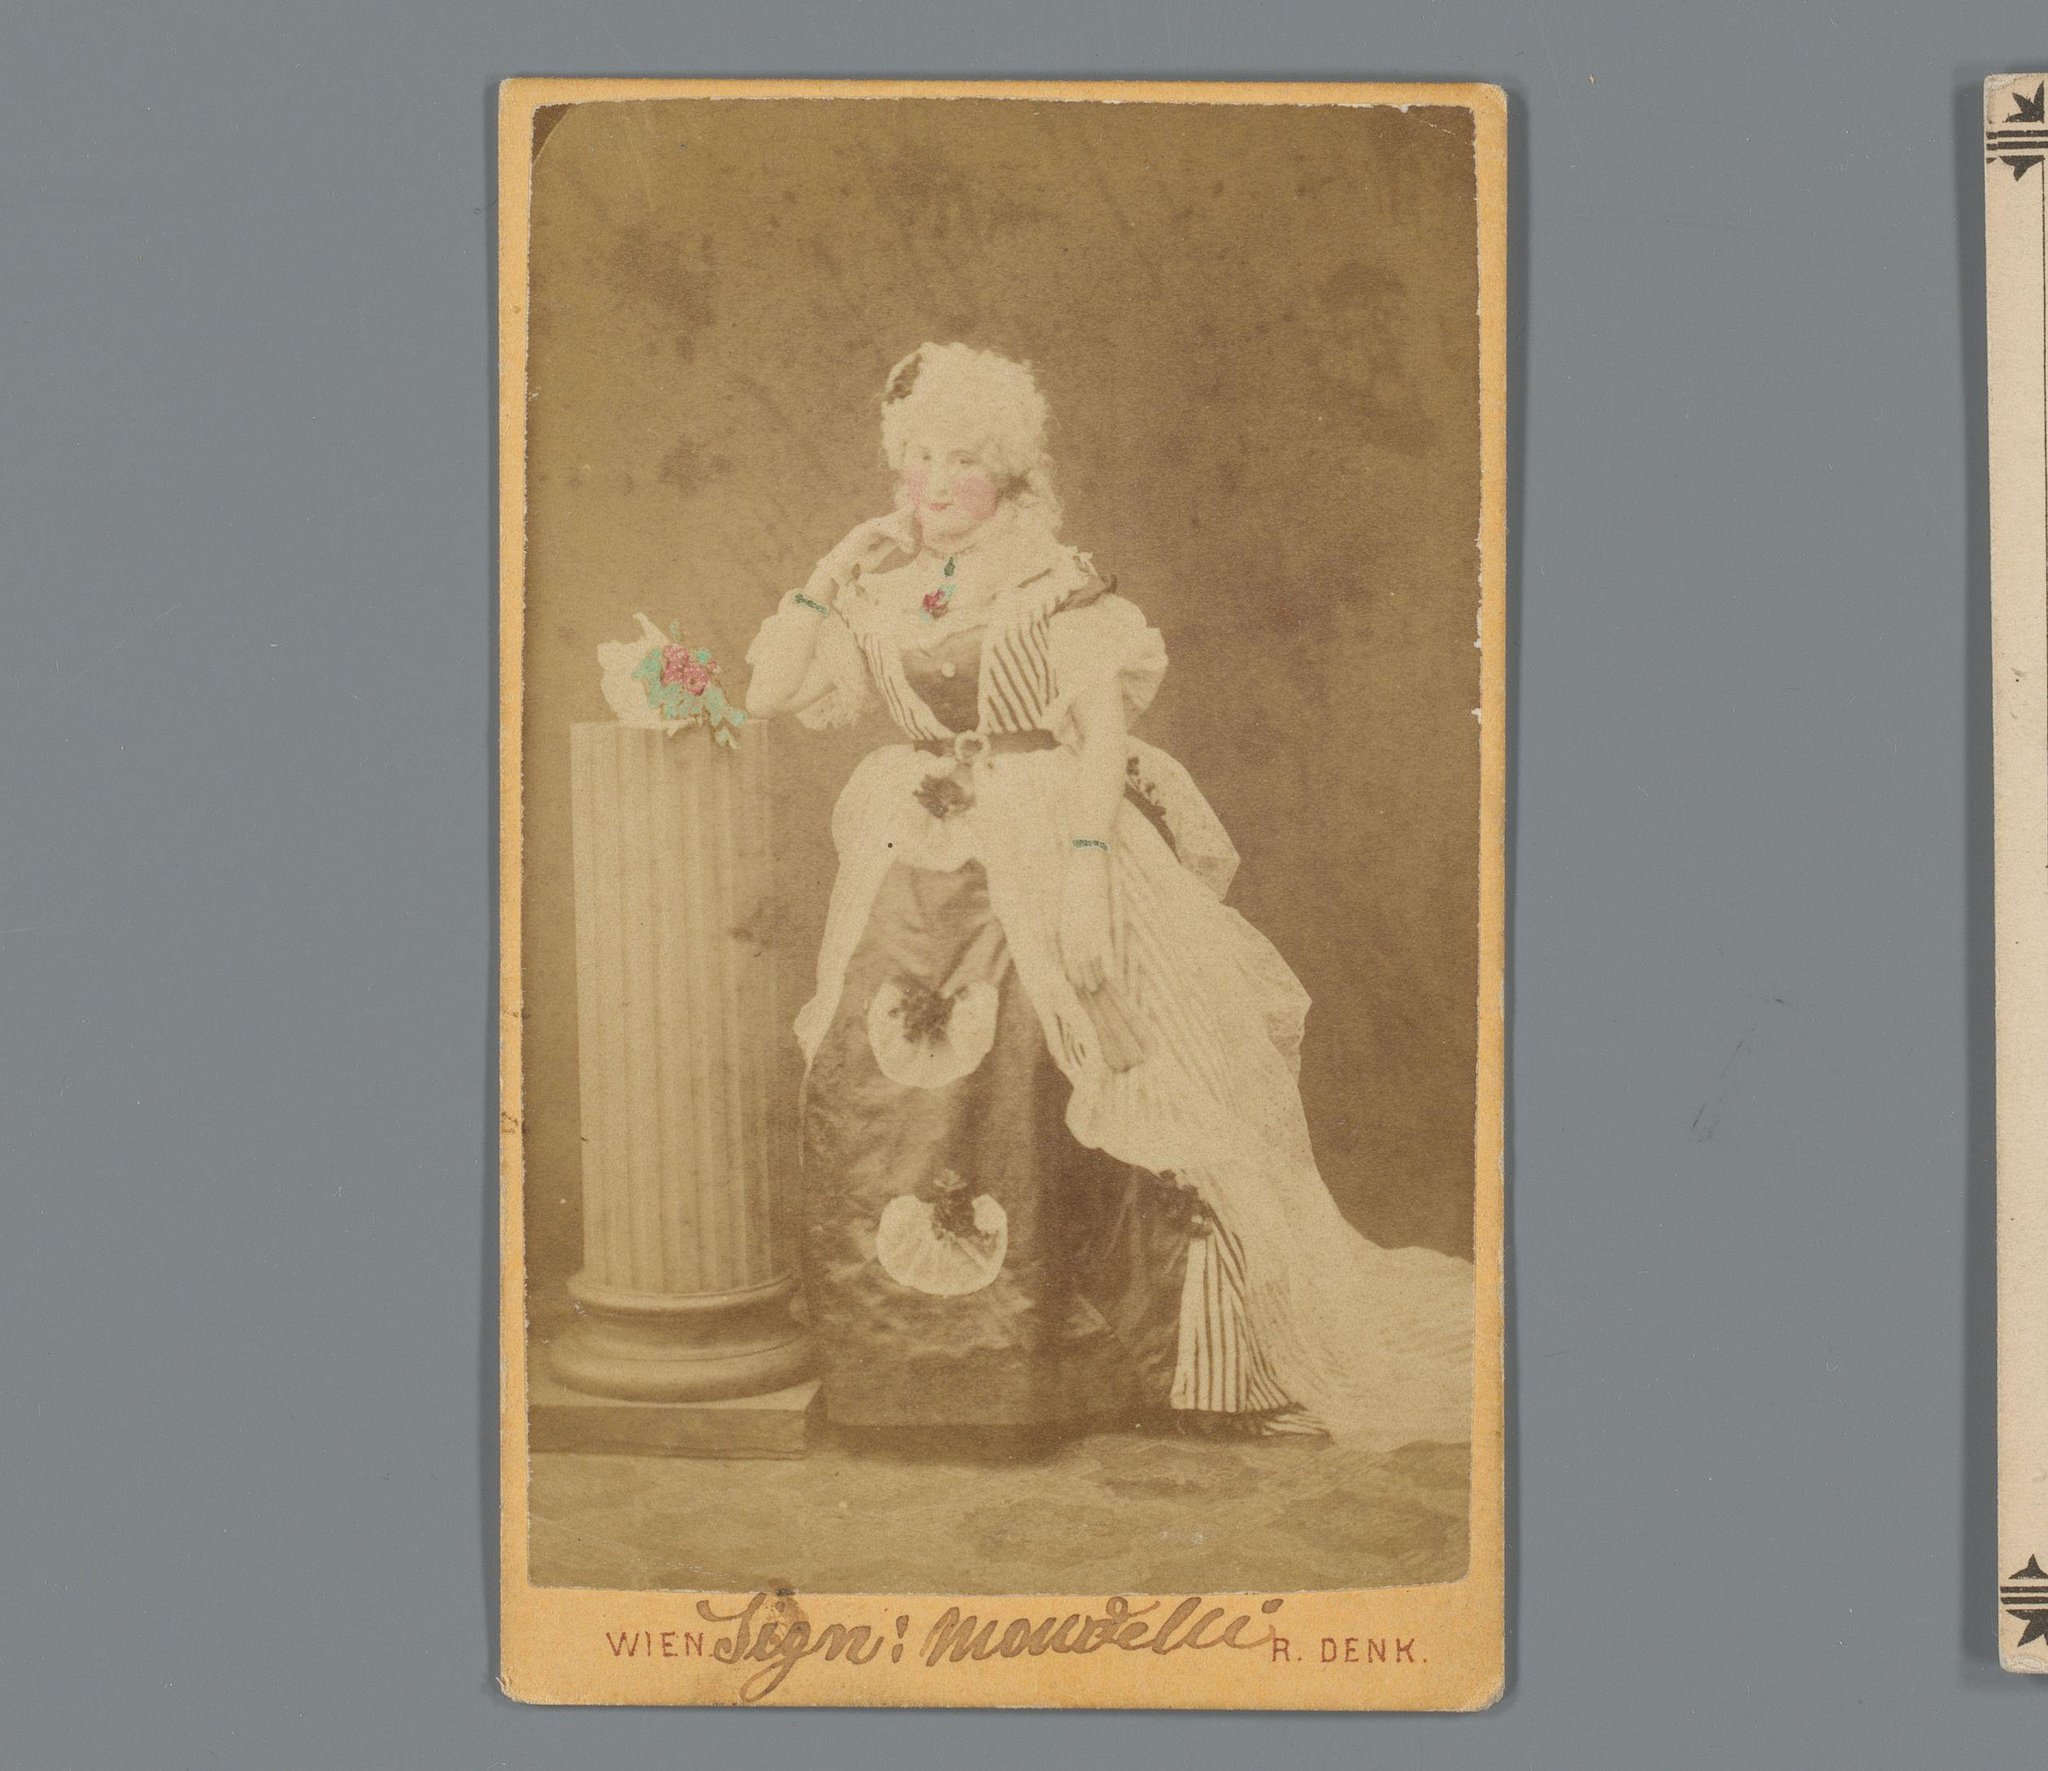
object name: photograph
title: Sign. Mondelli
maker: r. denk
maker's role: fotograaf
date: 1860-1880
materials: cardboard, photographic support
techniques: albumen print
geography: vienna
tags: advertising, historical persons - bb - woman, opera-singer (female)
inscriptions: inscription: ‘Sign. Elenore Mondelli (...)’, inscription: ‘F. KRATZASCH[...]/ Theater Agenture’, inscription: ‘Retour on:’